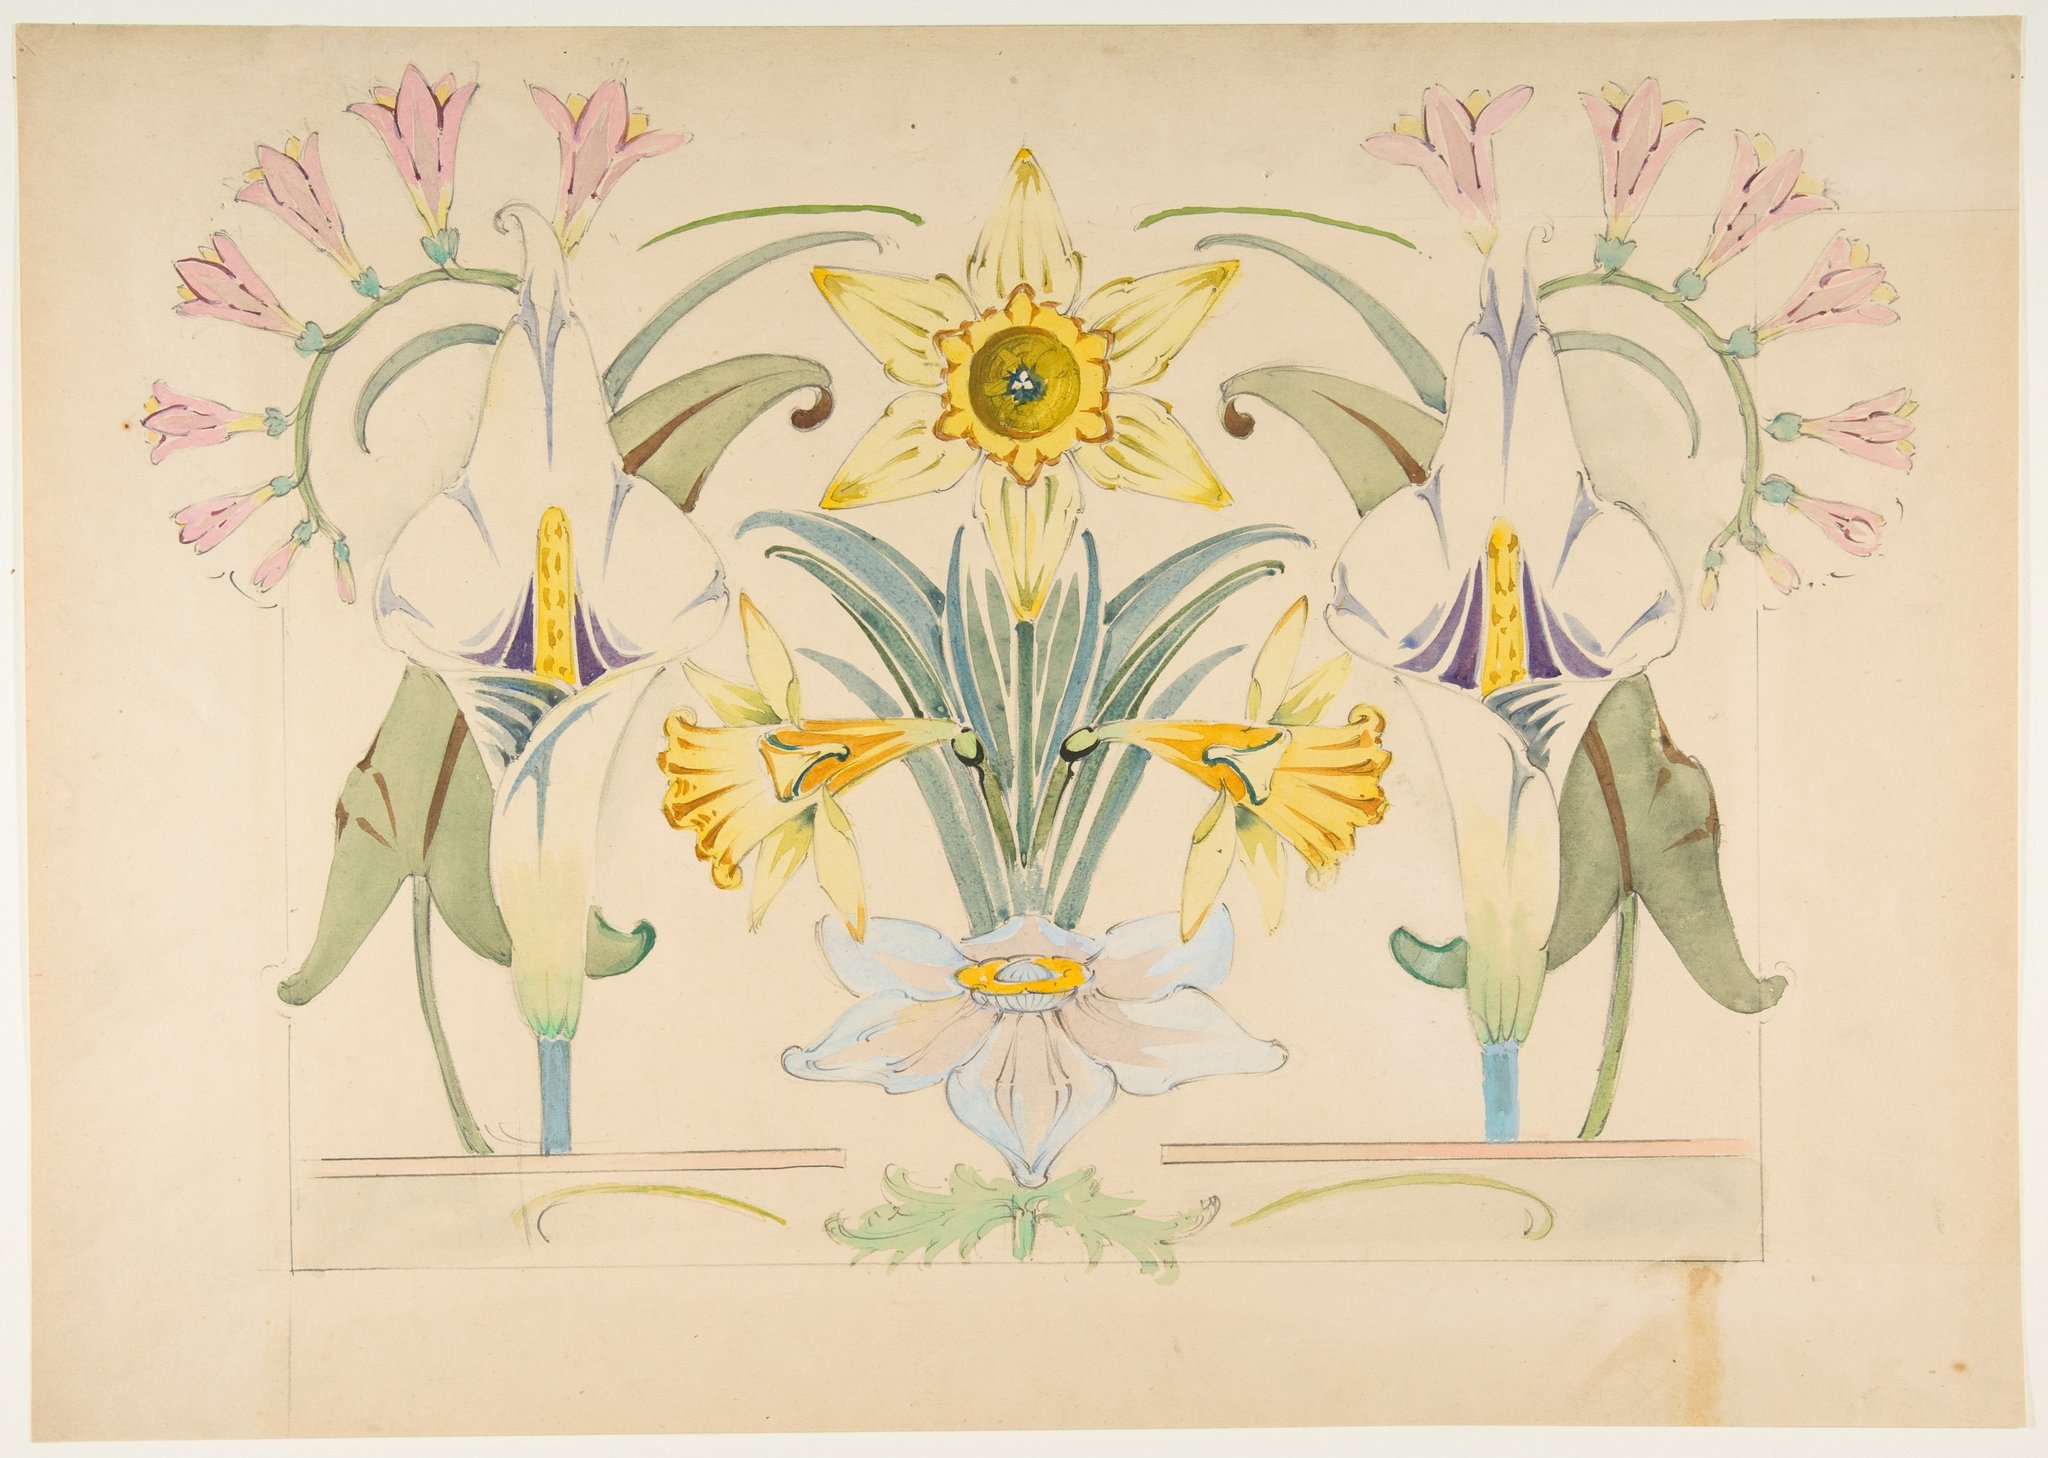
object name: drawing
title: Flower Design: Daffodils and Calla Lilies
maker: anonymous, french, 19th century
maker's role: artist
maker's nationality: french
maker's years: 1800-1900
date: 1801-1900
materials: gouache, graphite, watercolor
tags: lilies,leaves